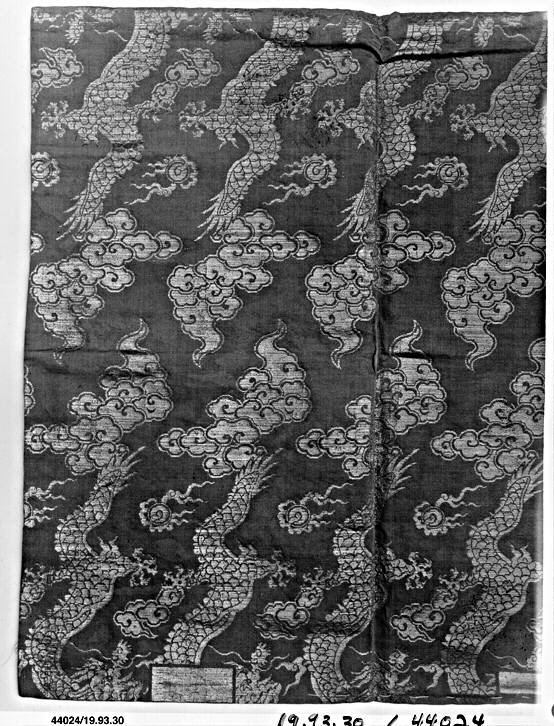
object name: altar cloth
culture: japanese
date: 1580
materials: silk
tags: dragons